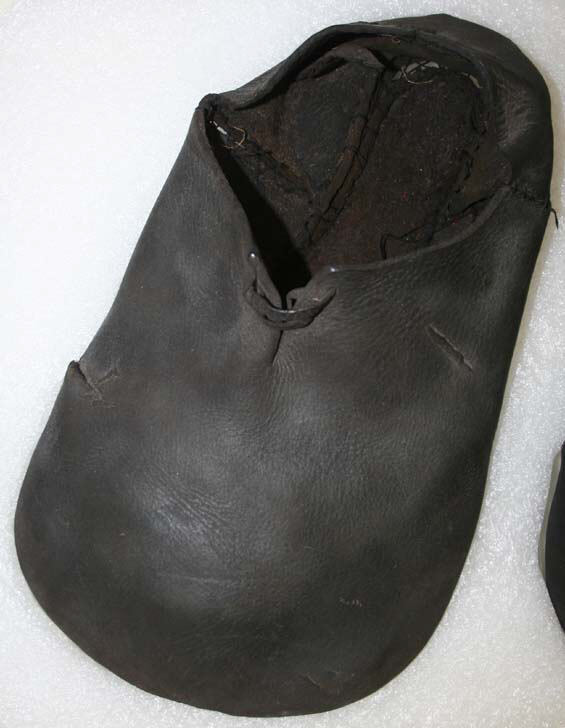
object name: shoe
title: Shoes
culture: european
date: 1501-1700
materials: leather